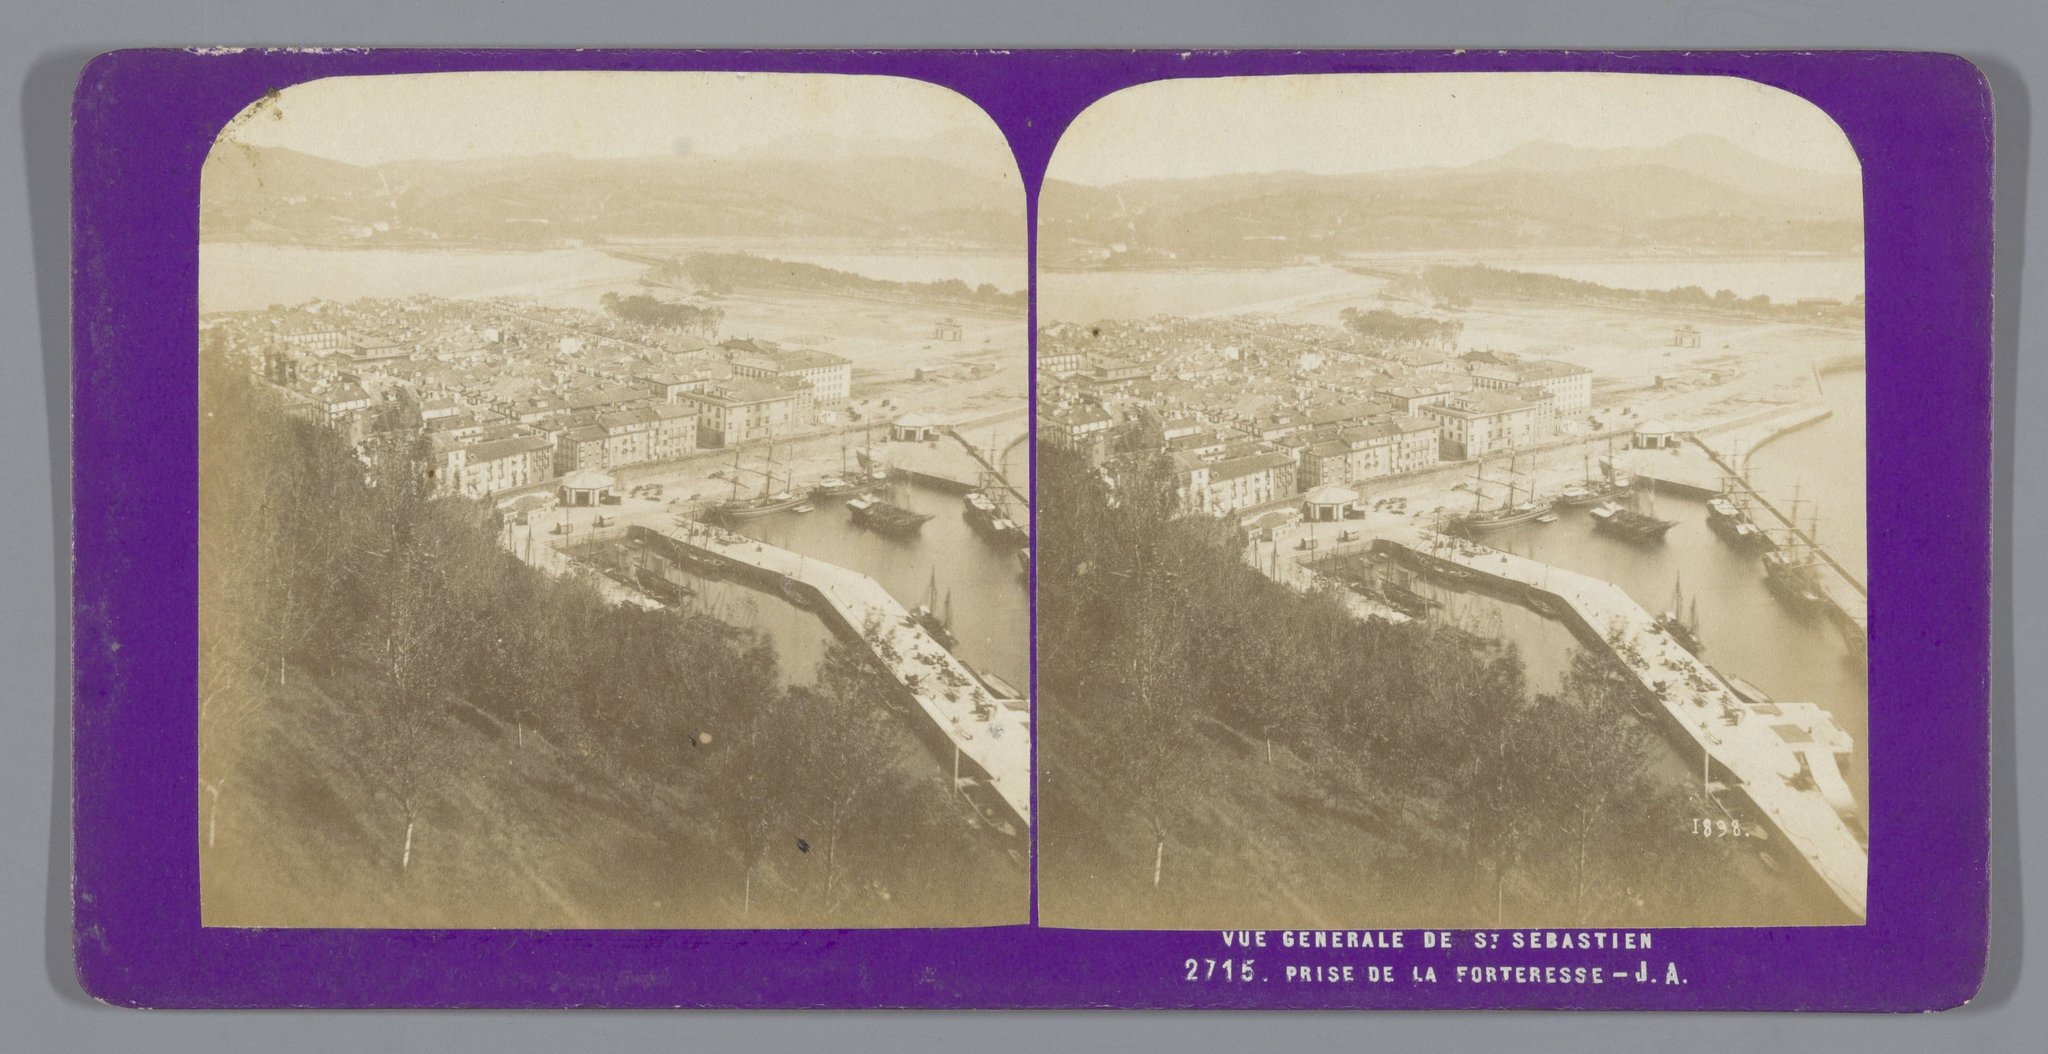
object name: stereograph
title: Gezicht op San Sebastián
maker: jean andrieu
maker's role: fotograaf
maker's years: 1816-1872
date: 1862-1876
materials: cardboard, photographic support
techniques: albumen print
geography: basque country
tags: city-view in general; 'veduta'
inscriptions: number: ‘2715.’